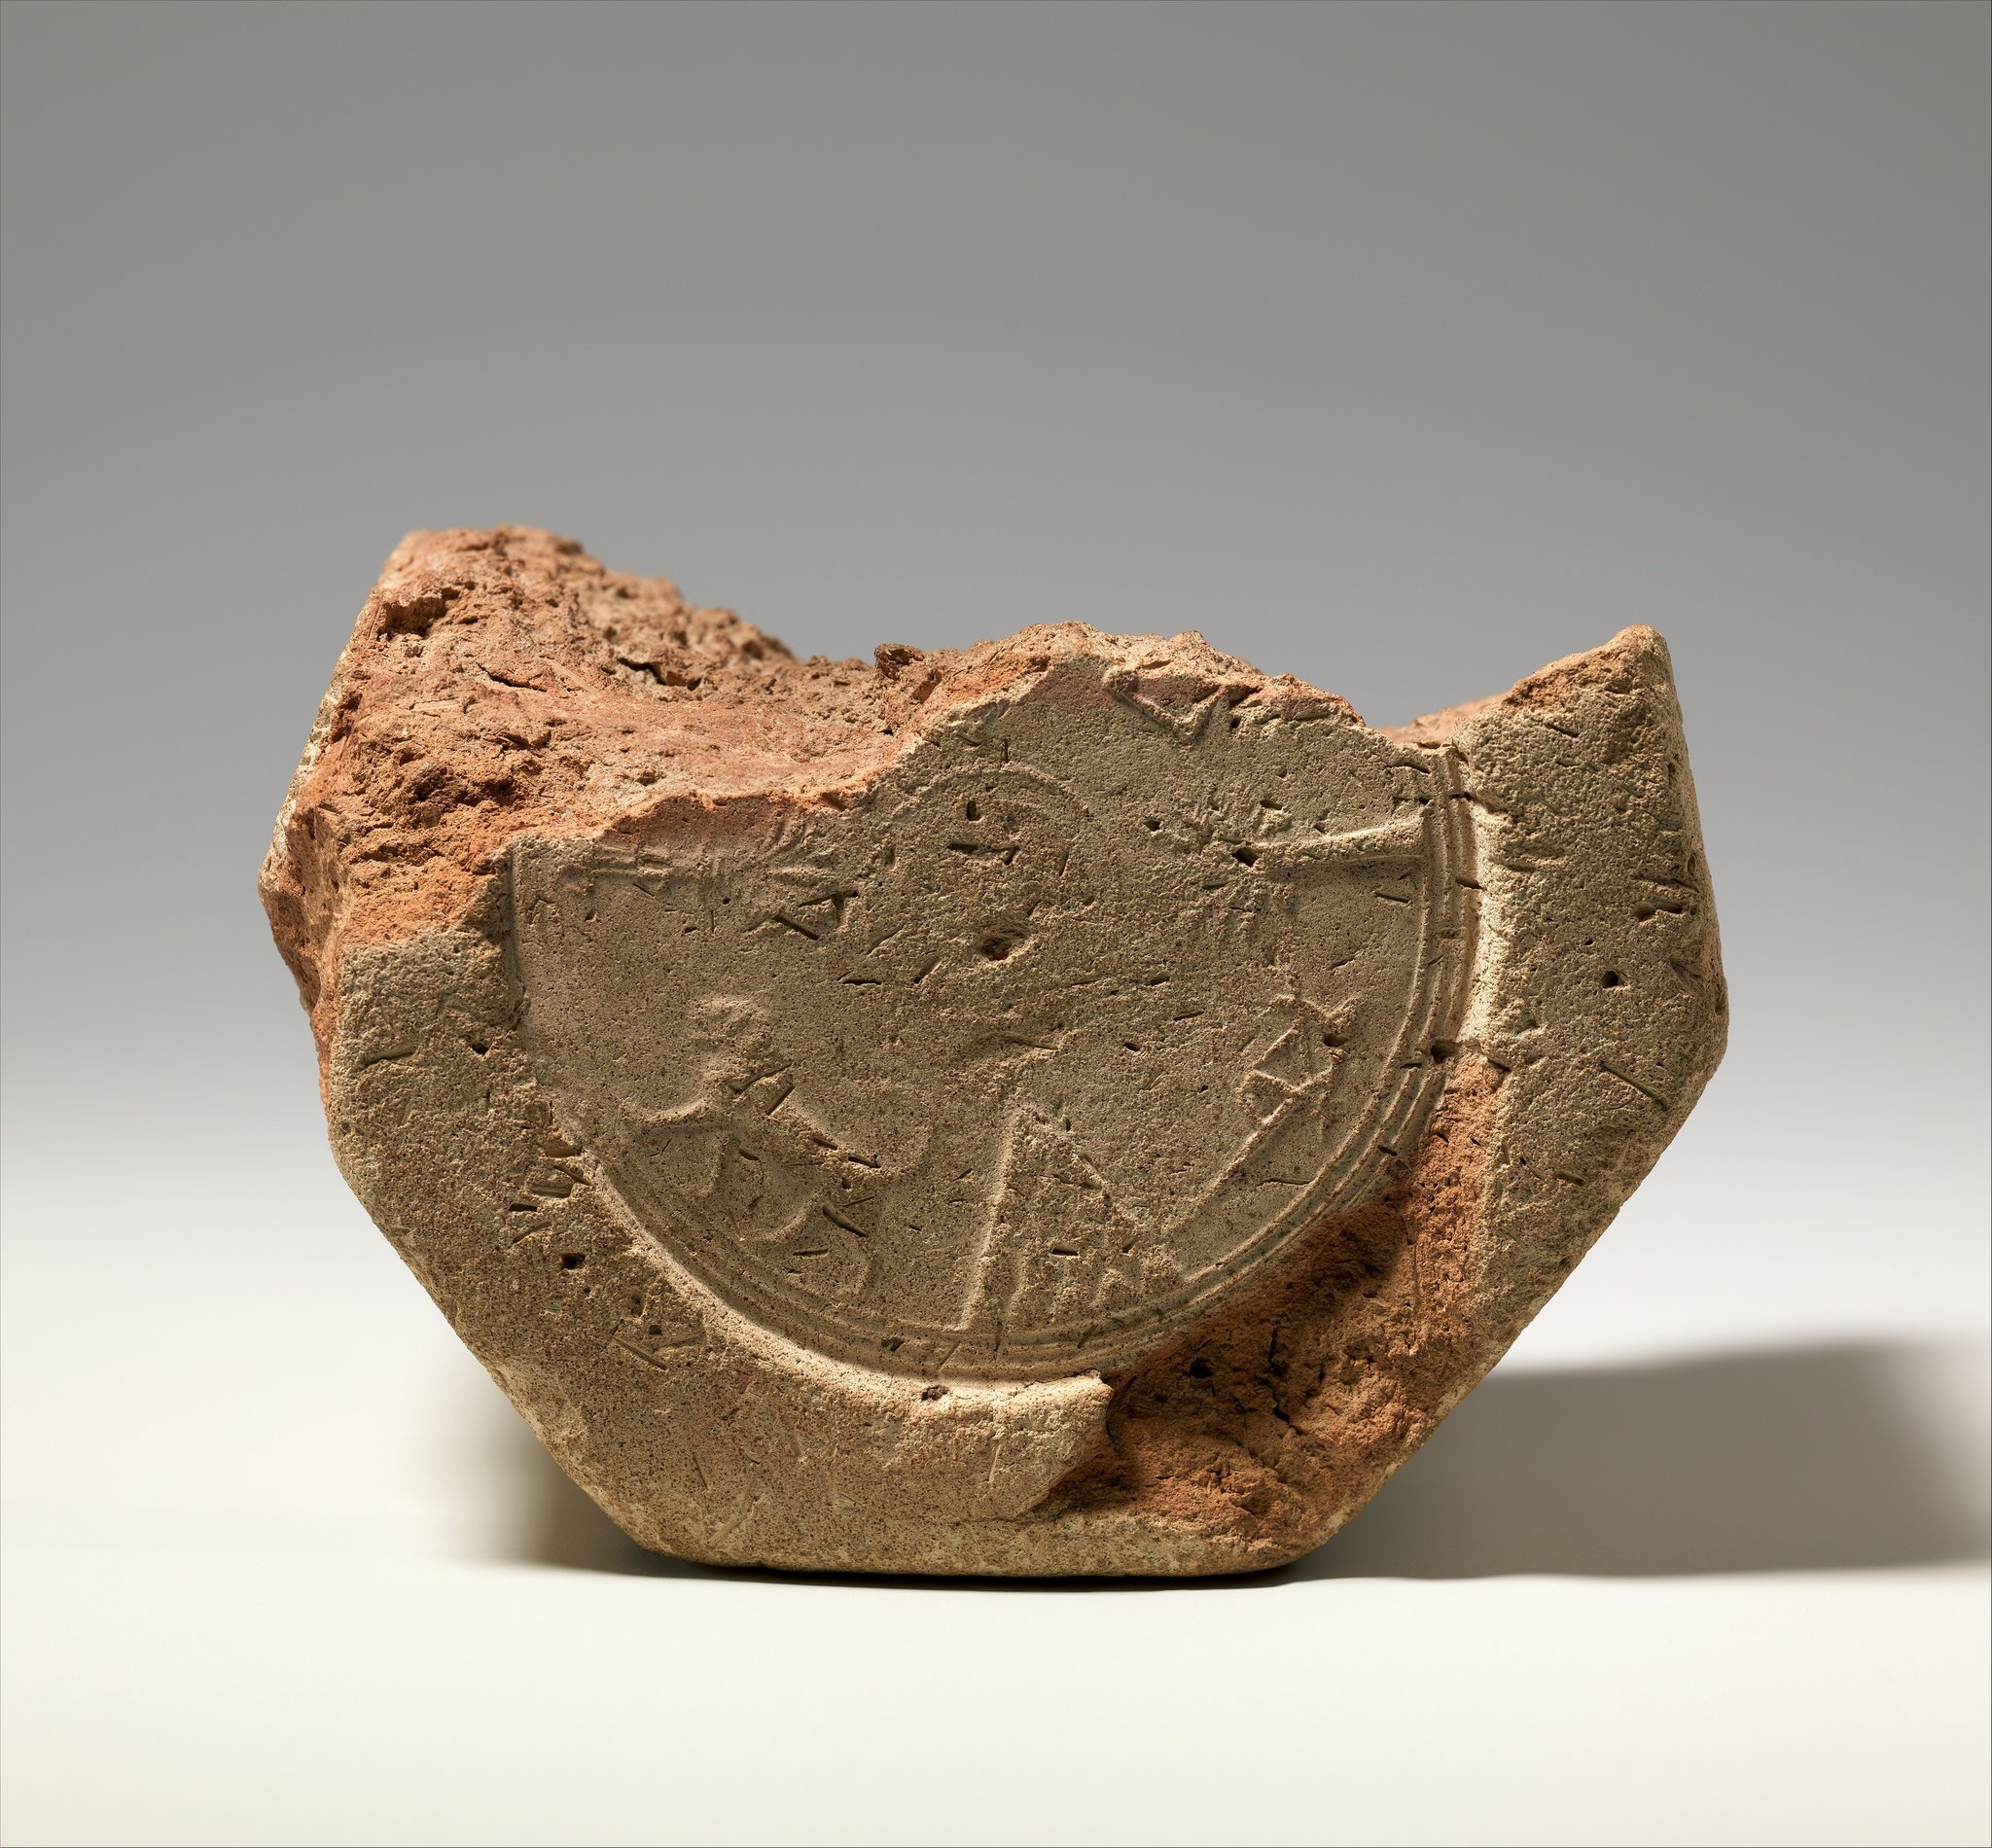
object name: cuneiform prism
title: Cuneiform prism describing the restoration of Babylon by Esarhaddon, stamped with Assyrian hieroglyphic inscription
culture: assyrian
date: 676-672 BCE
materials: clay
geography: mesopotamia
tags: lions